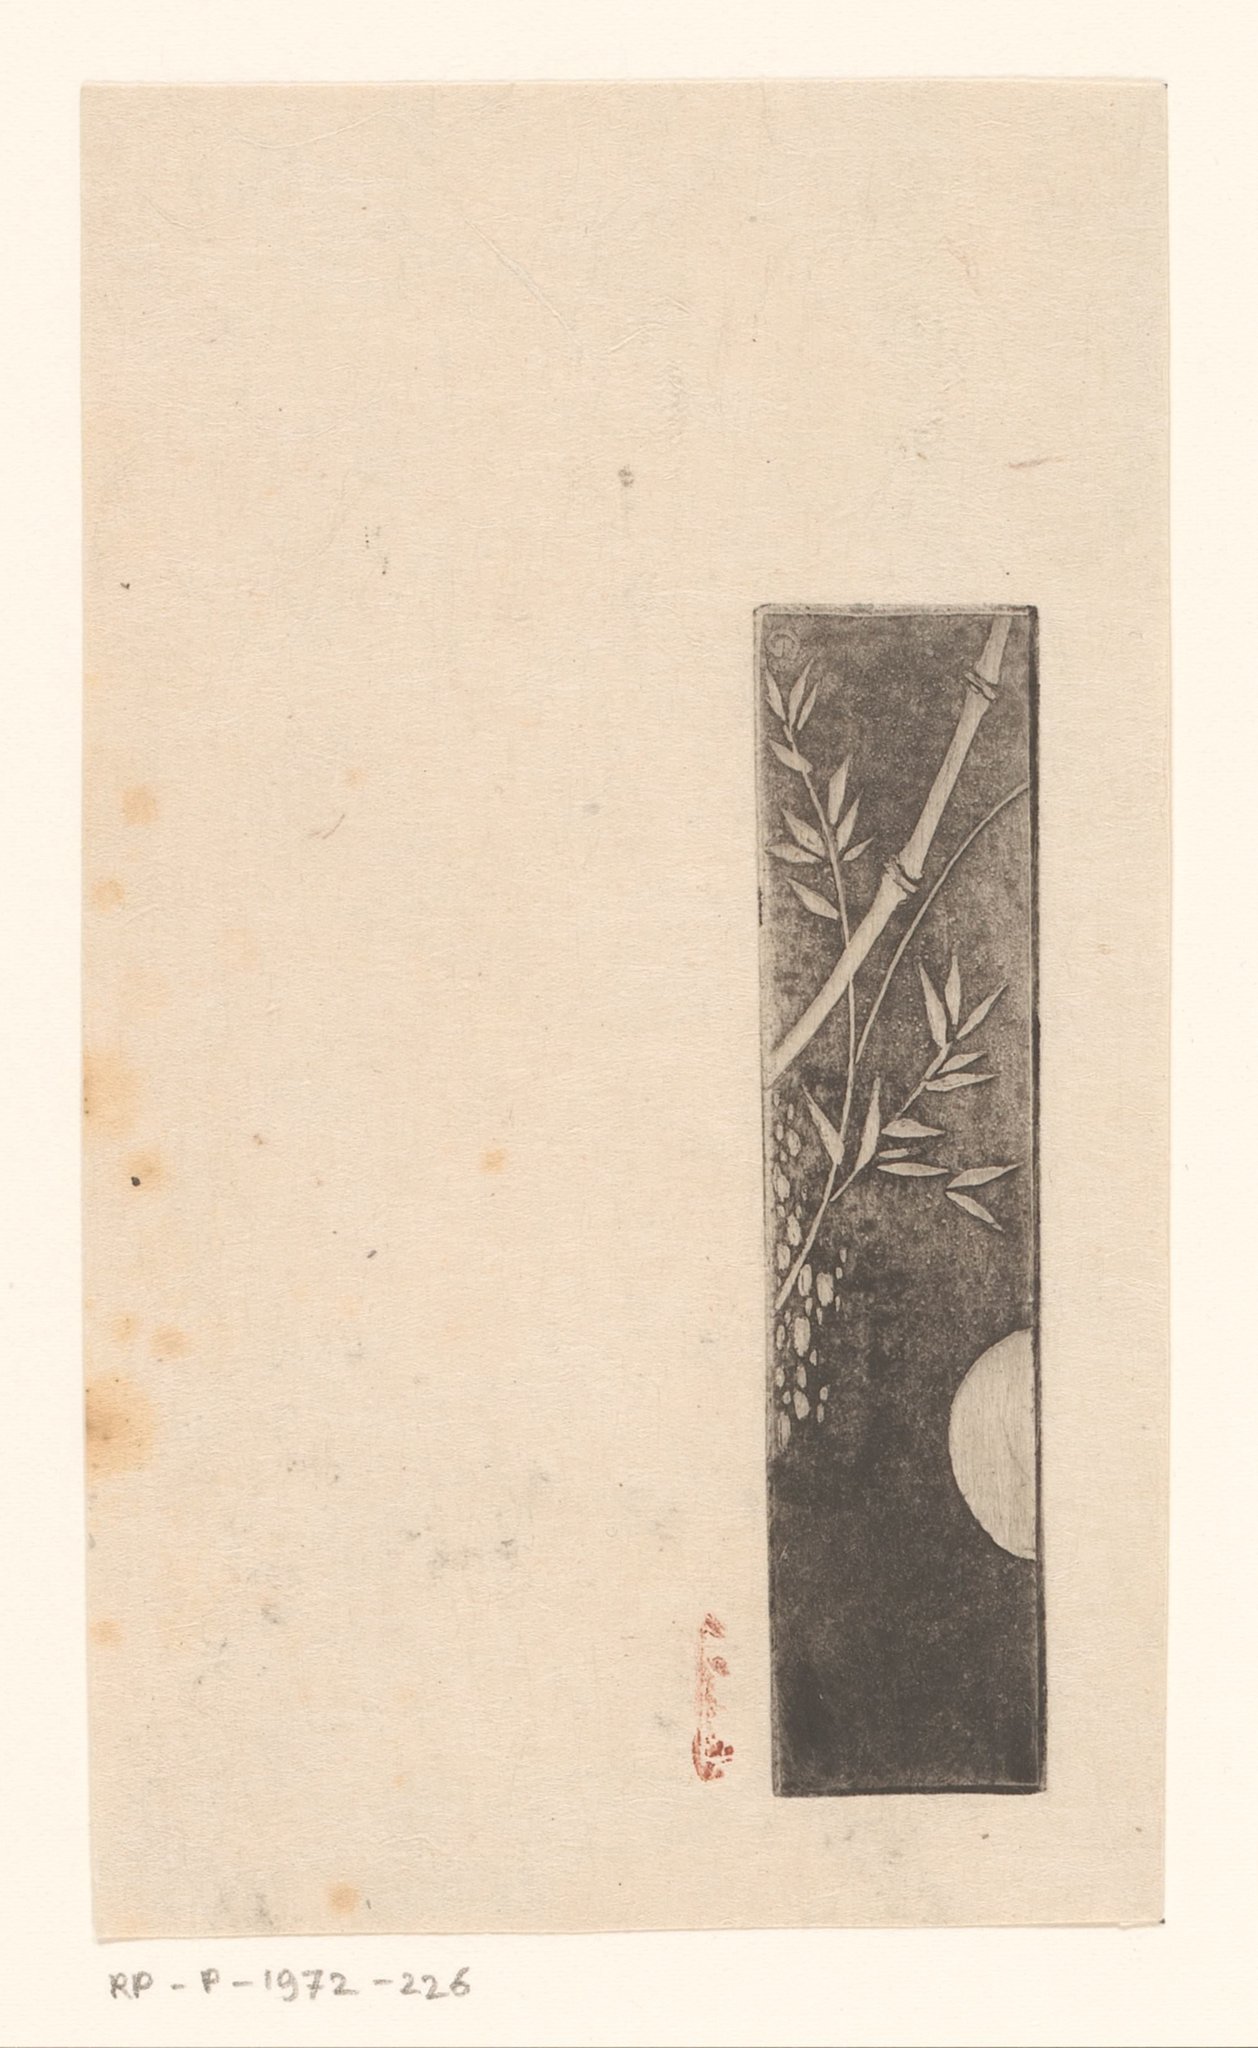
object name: print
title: Bamboescheut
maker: henri charles guérard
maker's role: print maker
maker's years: 1846-1897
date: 1856-1897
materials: paper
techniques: aquatint, etching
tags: plants (in general)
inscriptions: collector's mark: Lugt 2760, collector's mark: Lugt 2228